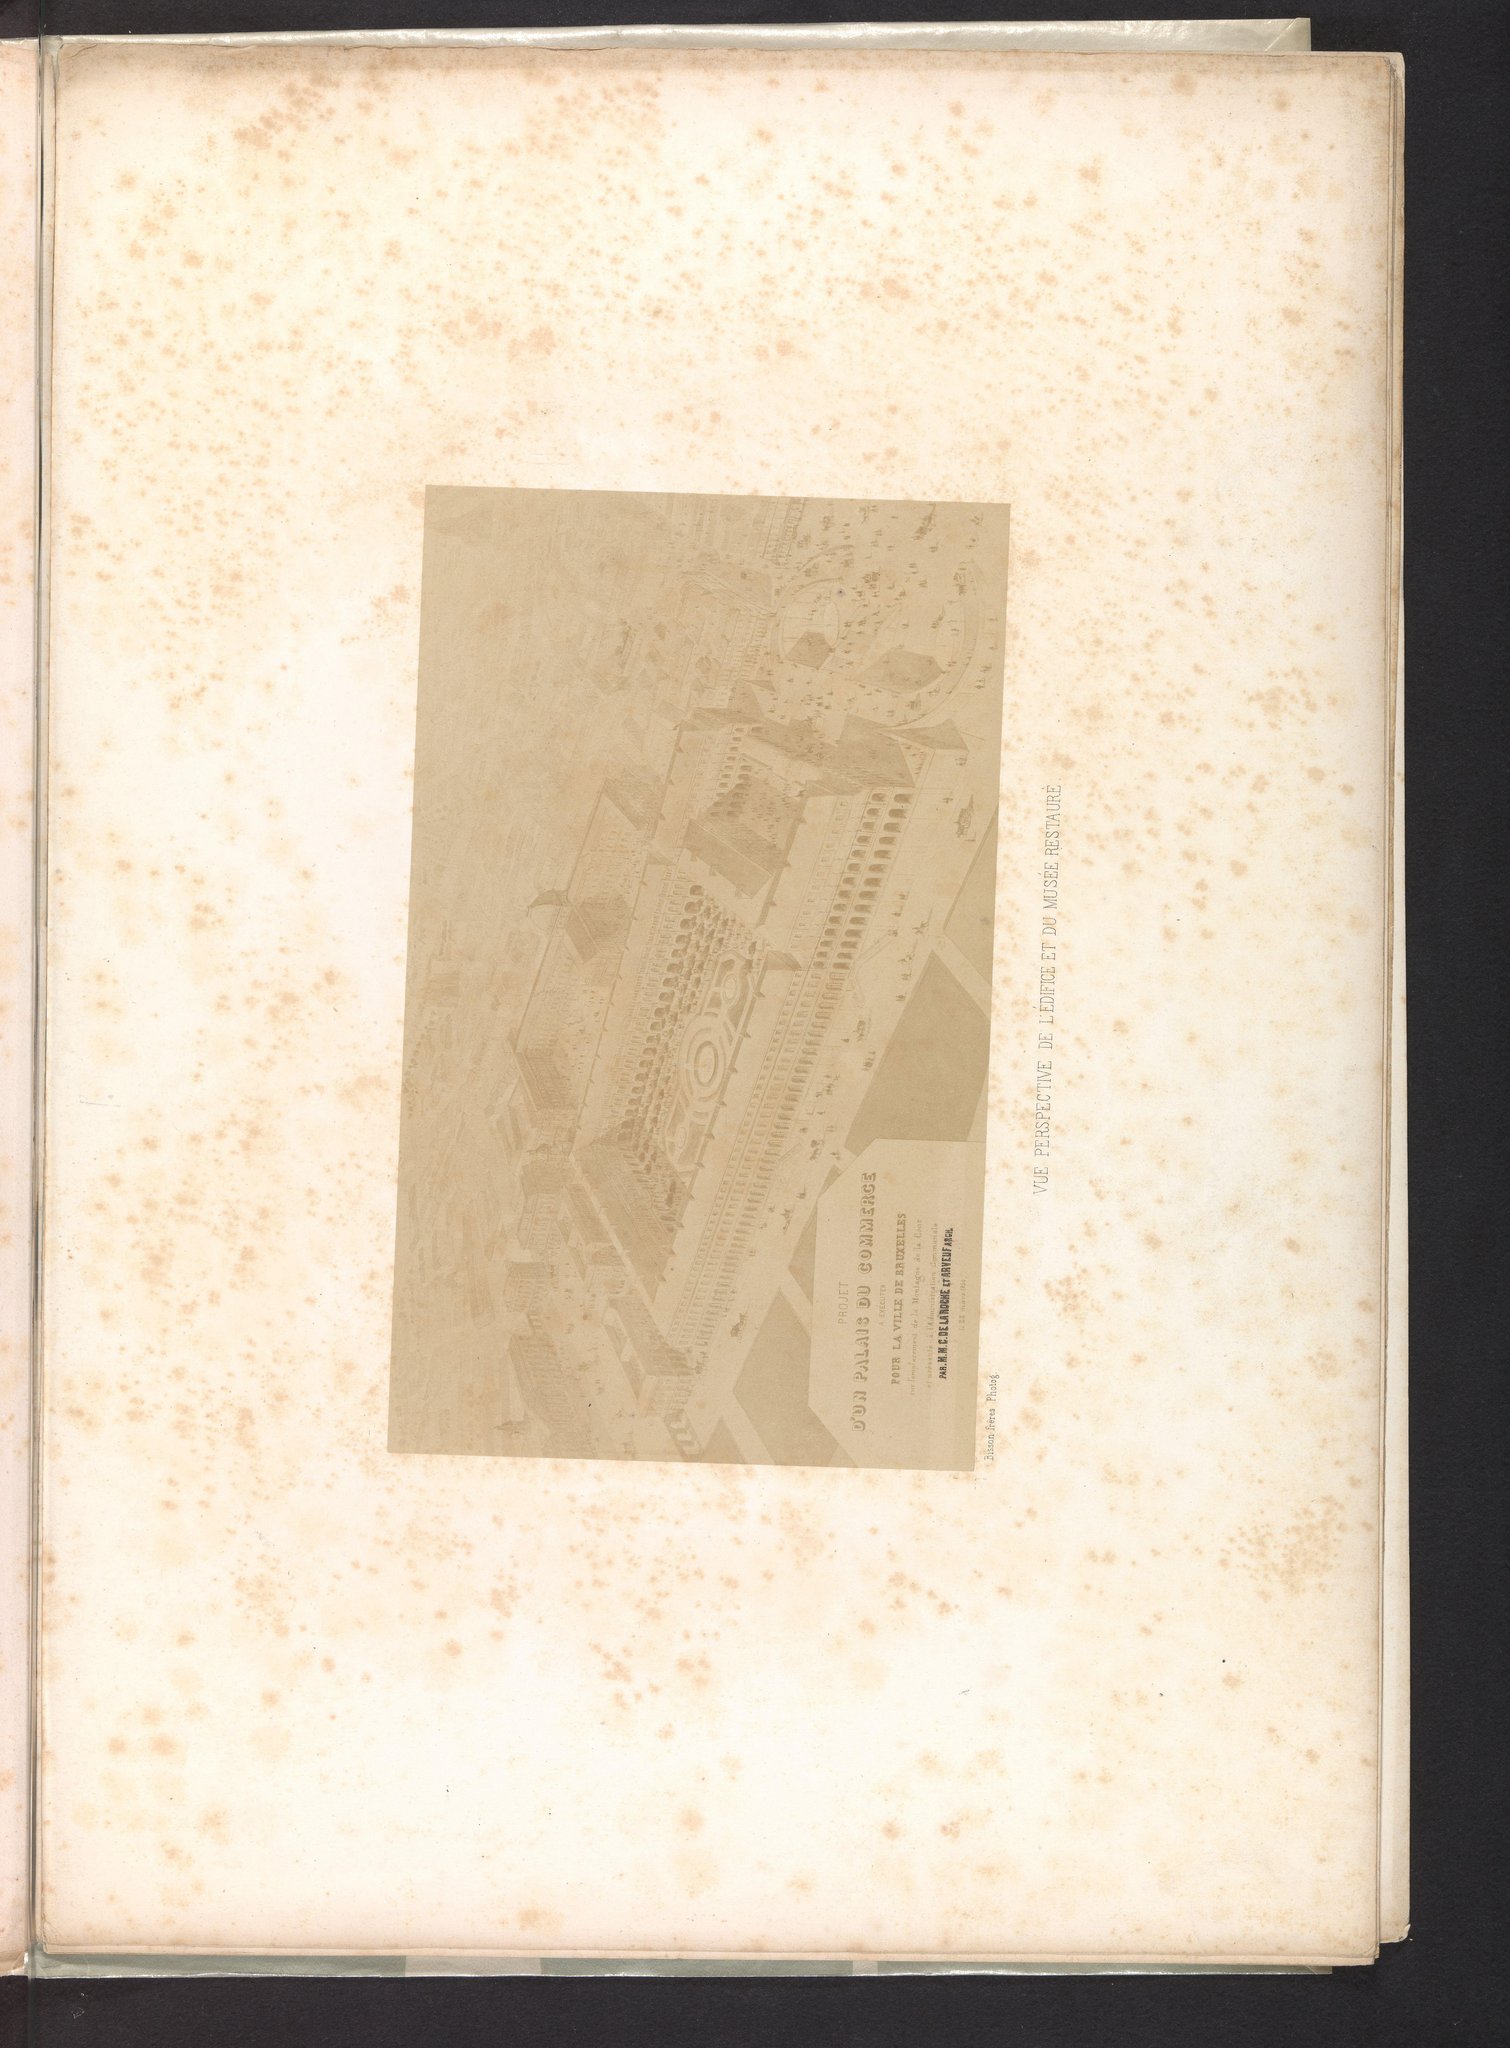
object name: photograph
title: Fotoreproductie van een tekening, voorstellende een exterieur van een handelsgebouw te Brussel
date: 1853-1854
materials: photographic support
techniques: albumen print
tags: chamber of commerce, façade (of house or building)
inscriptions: inscription: ‘par M.M.C. de La Roche et Arveuf arch.’